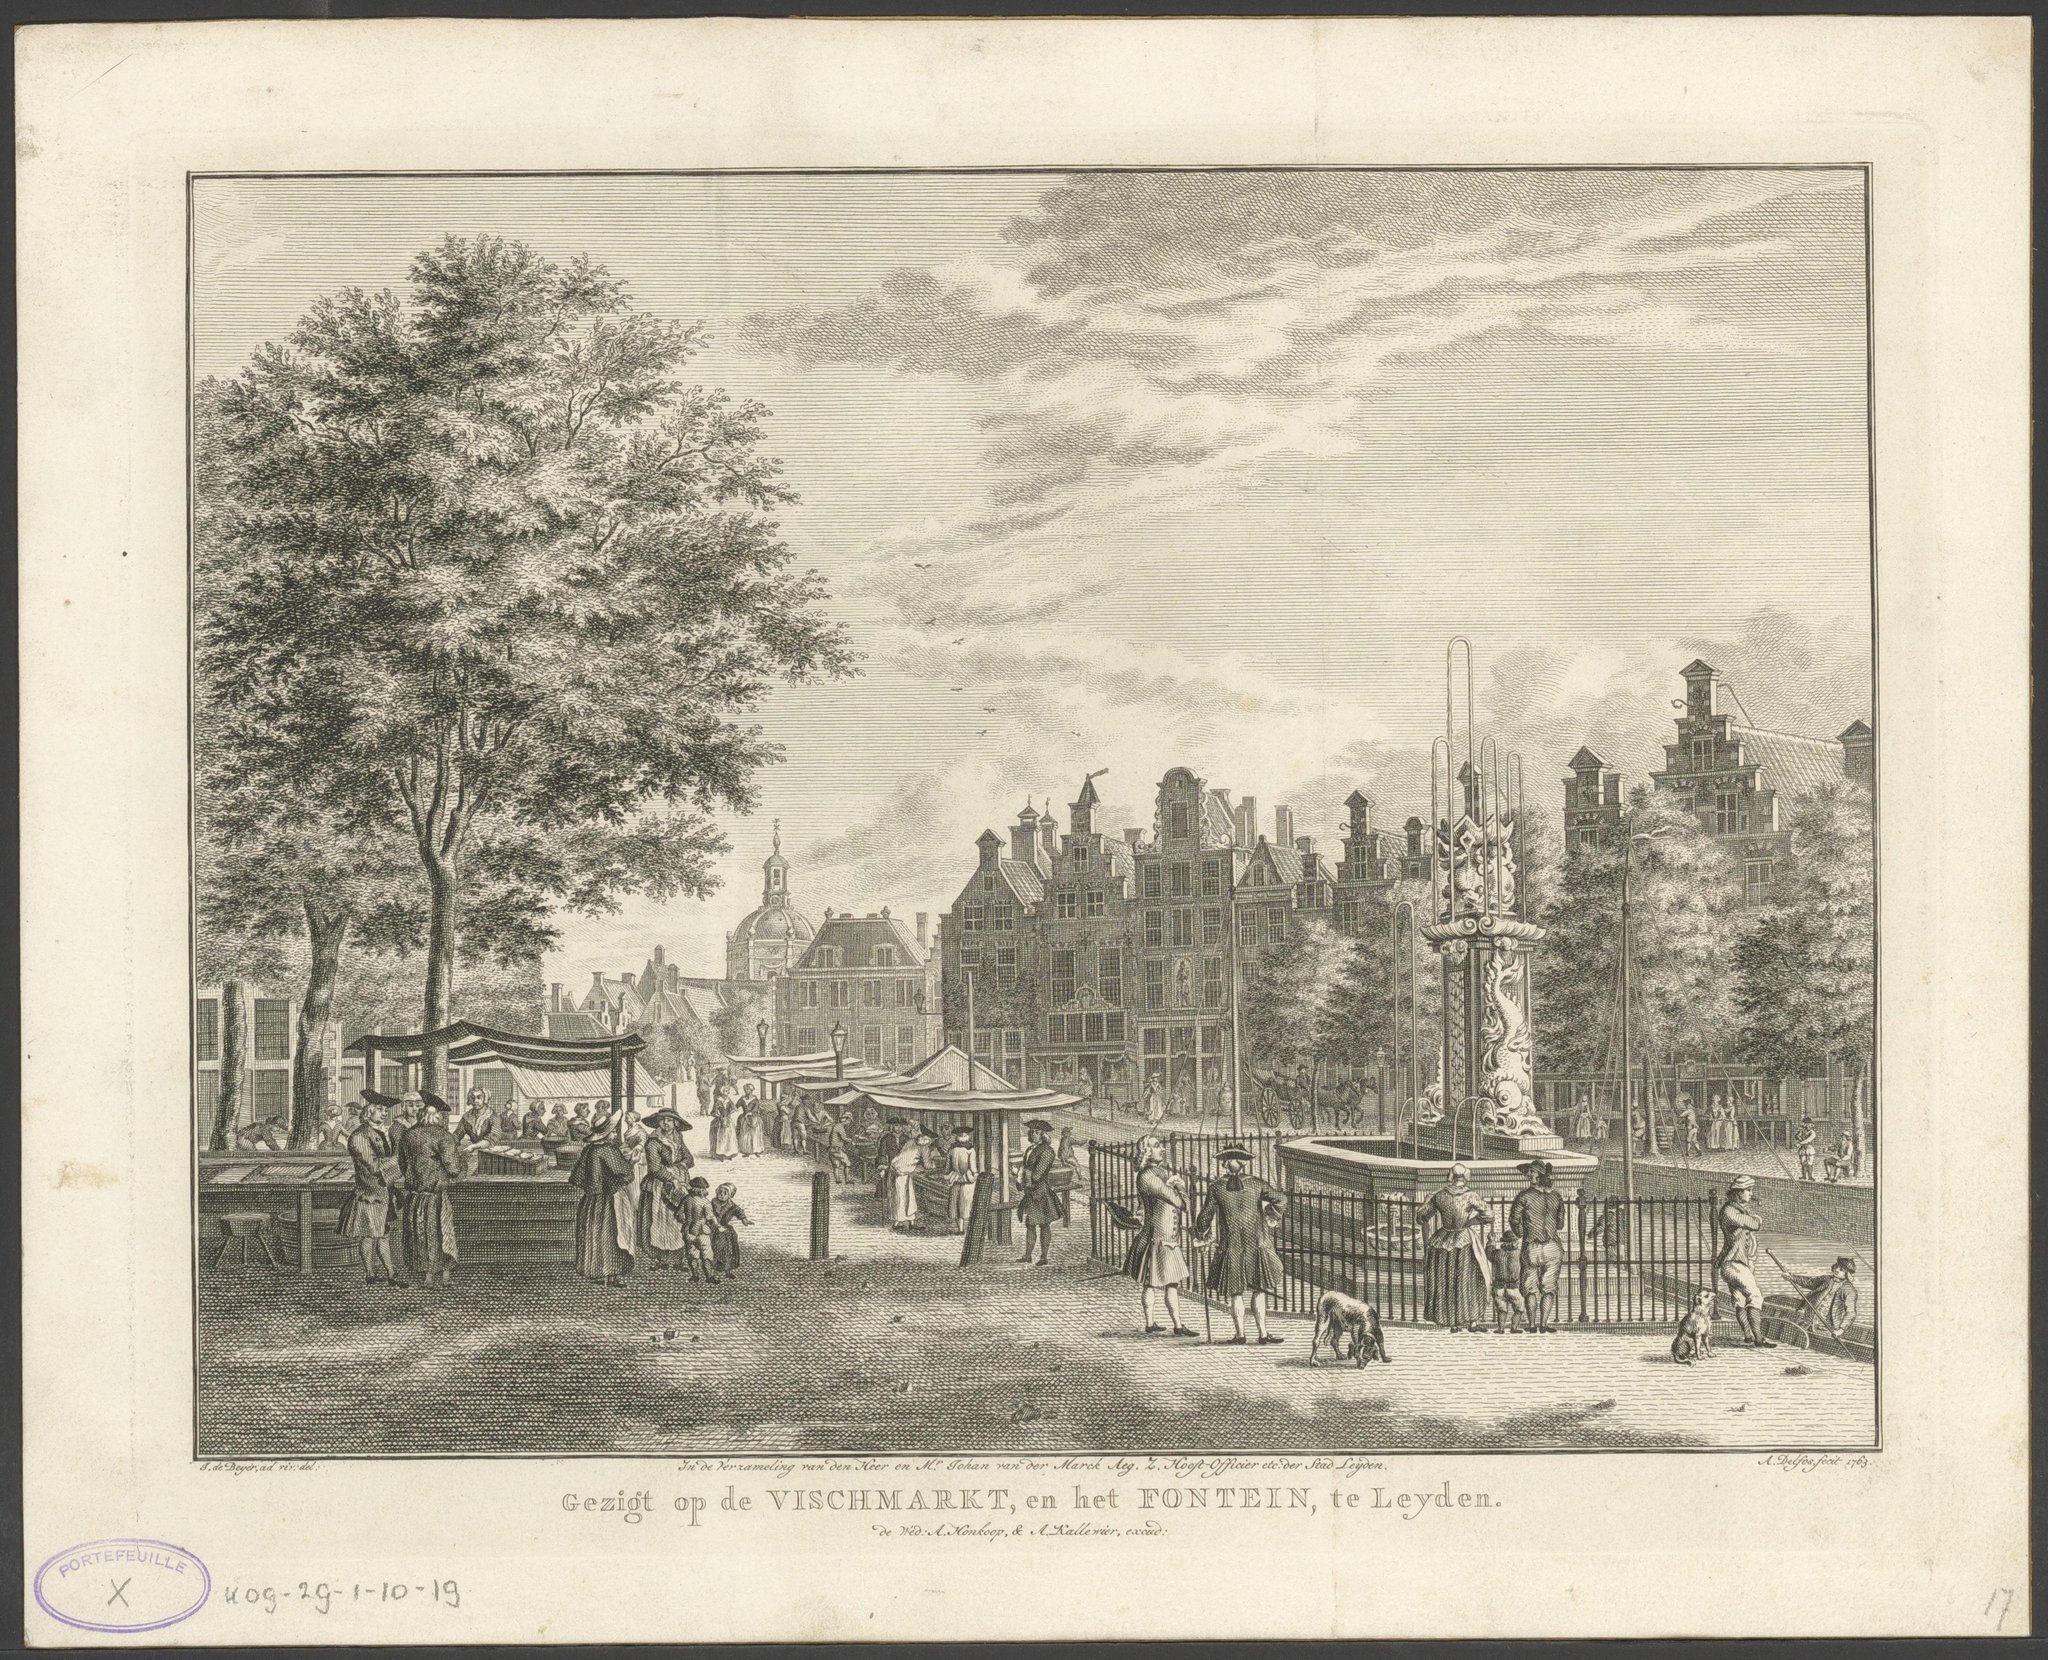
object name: print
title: Gezicht op de Vismarkt in Leiden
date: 1763-1770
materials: paper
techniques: engraving, etching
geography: amsterdam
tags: market, fish; still life of fishes, leiden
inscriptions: collector's mark: Lugt 1641, stamp, stamp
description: Gezicht op de Vismarkt te Leiden, met rechts de Vismarktfontein. Onderwerpsrubrieken binnen de Atlas Zeden en Gewoonten: Handel, nijverheid en verkeer, Marktwezen, Leiden.